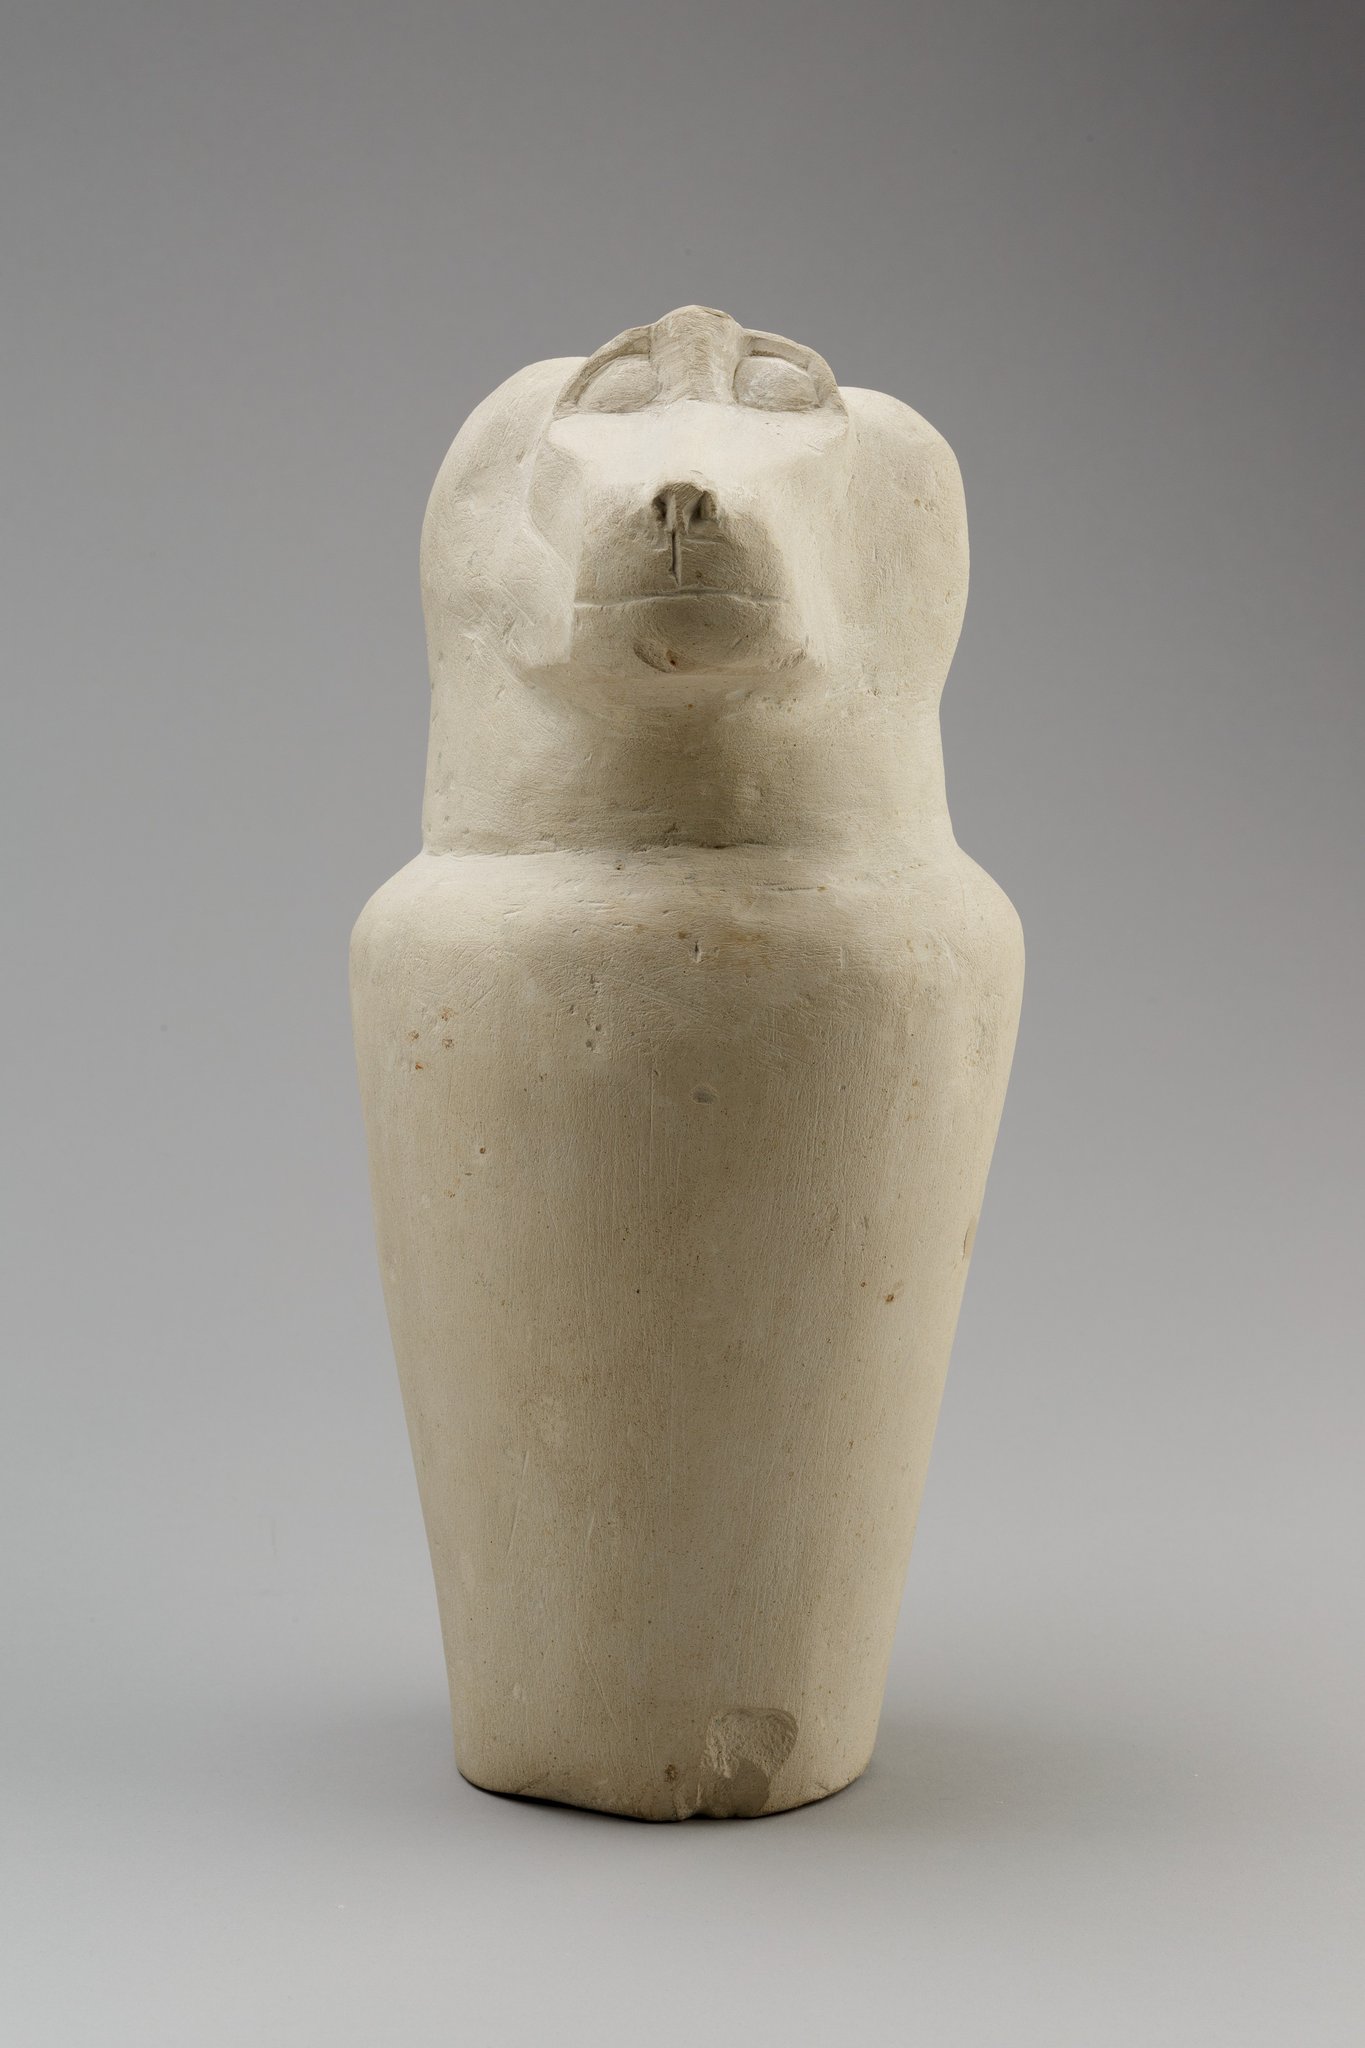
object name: canopic jar, dummy jar, baboon headed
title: Dummy canopic jar with baboon head (Hapy)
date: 712-664 BCE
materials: limestone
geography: egypt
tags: baboons